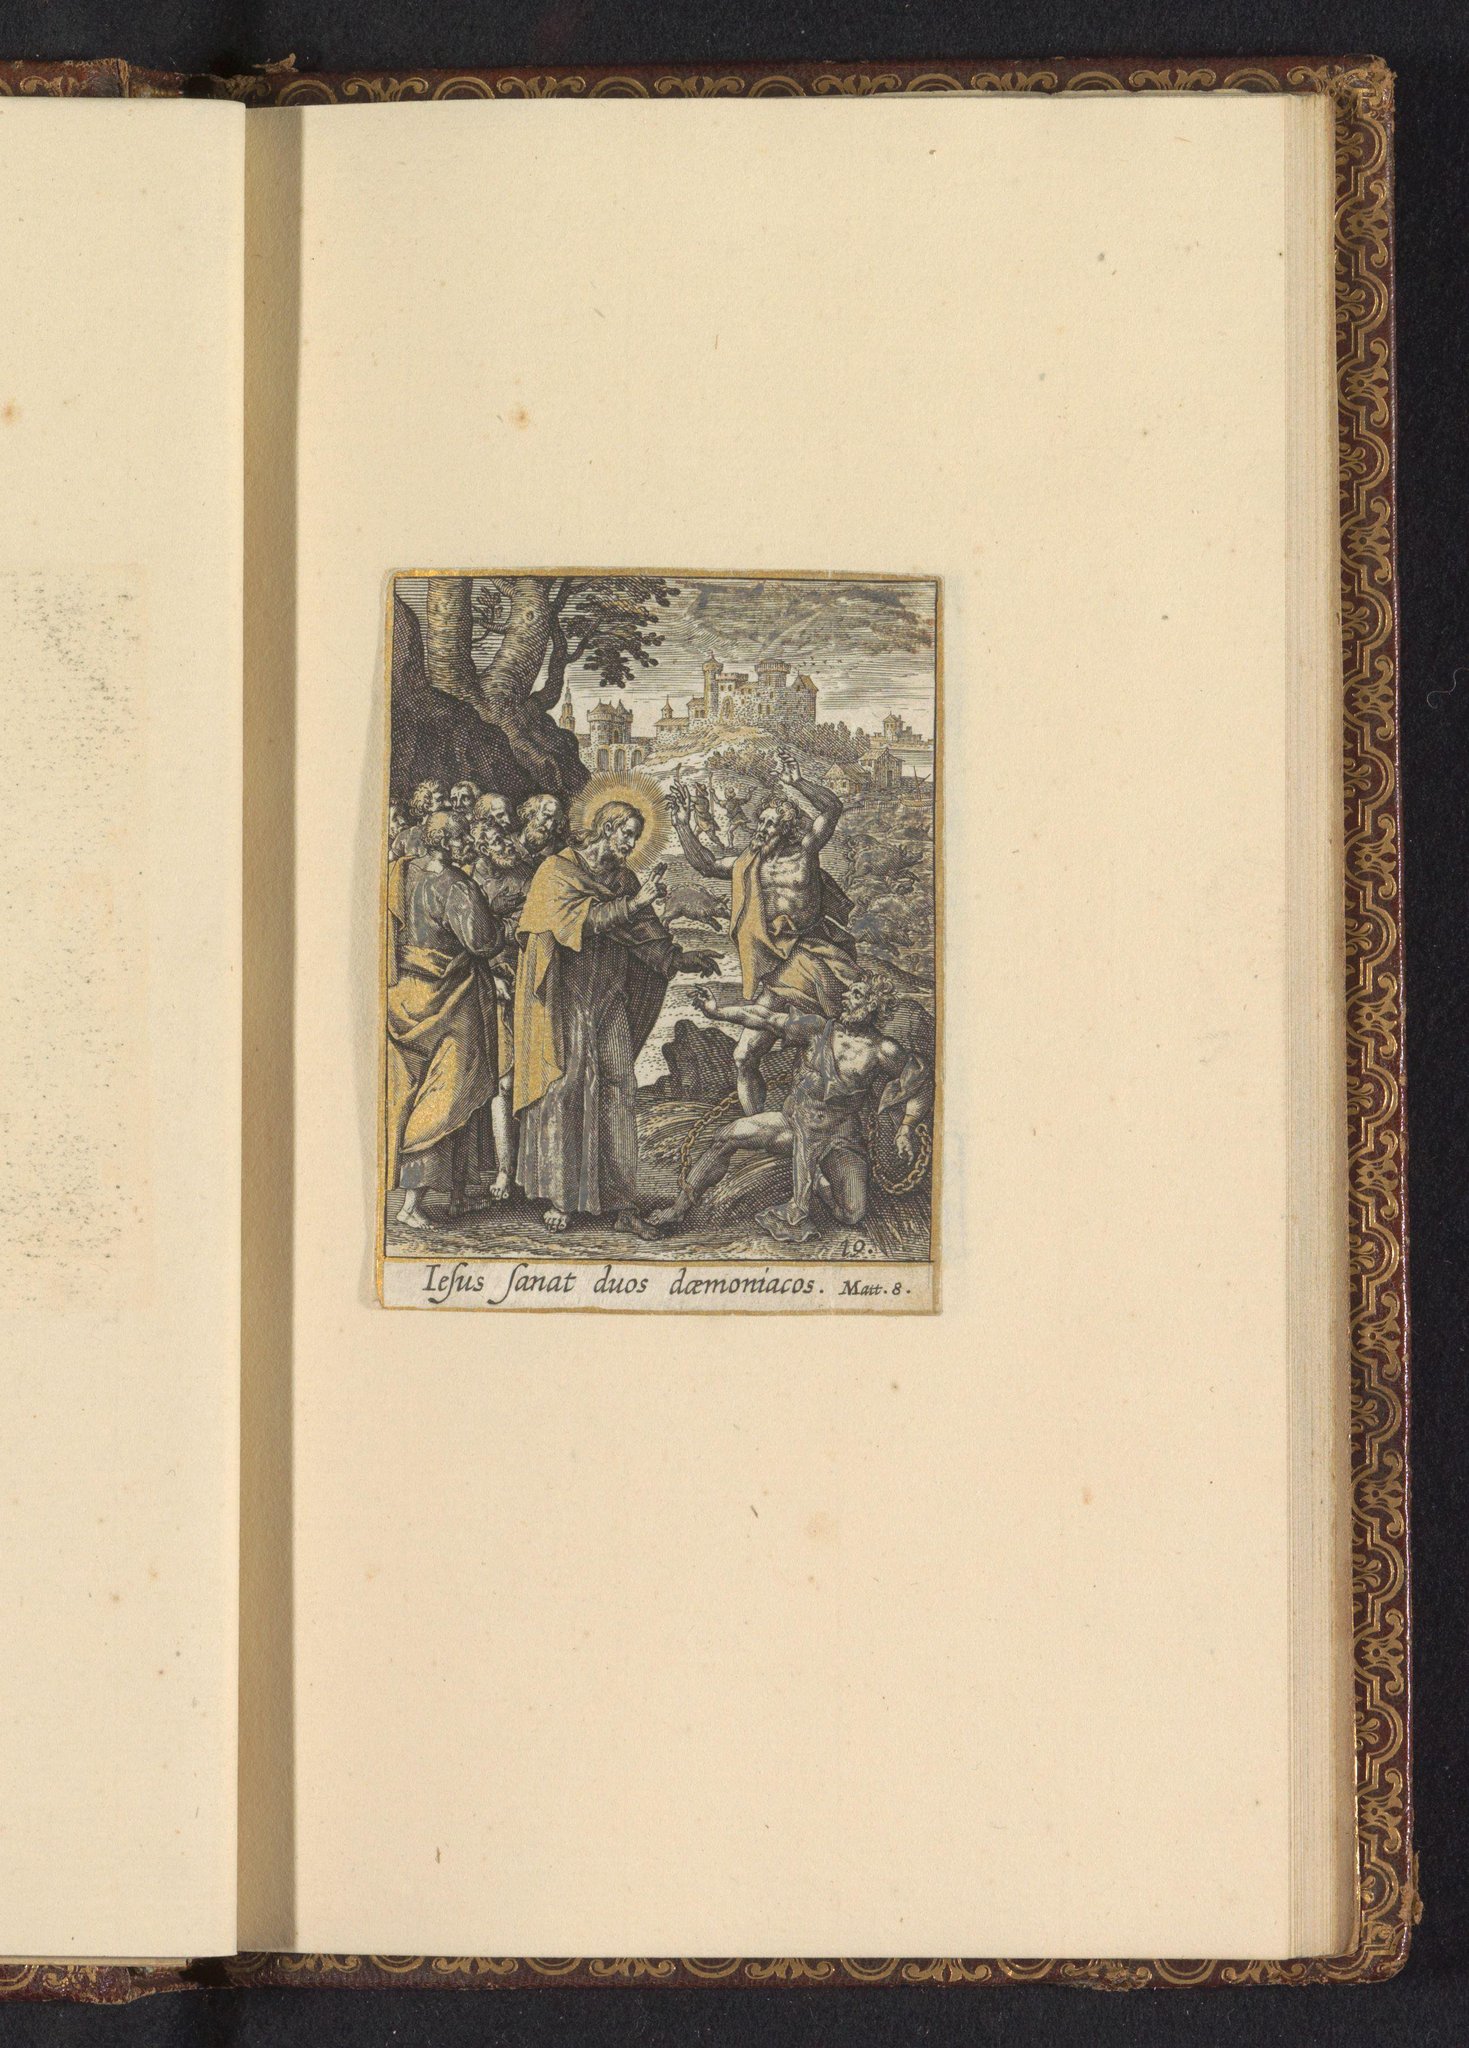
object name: print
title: Christus geneest twee bezeten mannen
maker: adriaen collaert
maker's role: draughtsman, print maker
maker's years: 1560-1618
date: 1580-1590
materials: gold, paper, silver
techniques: engraving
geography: antwerp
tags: healing of two (or one) possessed at gerasa (gadara) (matthew 8:28-34; mark 5:1-20; luke 8:26-39)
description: Christus geneest twee door duivels bezeten mannen in het gebied van de Gerasenen. Onderdeel van de prentserie over het leven van Christus: Vita Iesu Salvatoris varijs iconibus ab Adriano Collaert expressa. In prentalbum met twee reeksen van respectievelijk 34 en 25 gravures met scènes uit het leven en het lijdensverhaal van Christus.